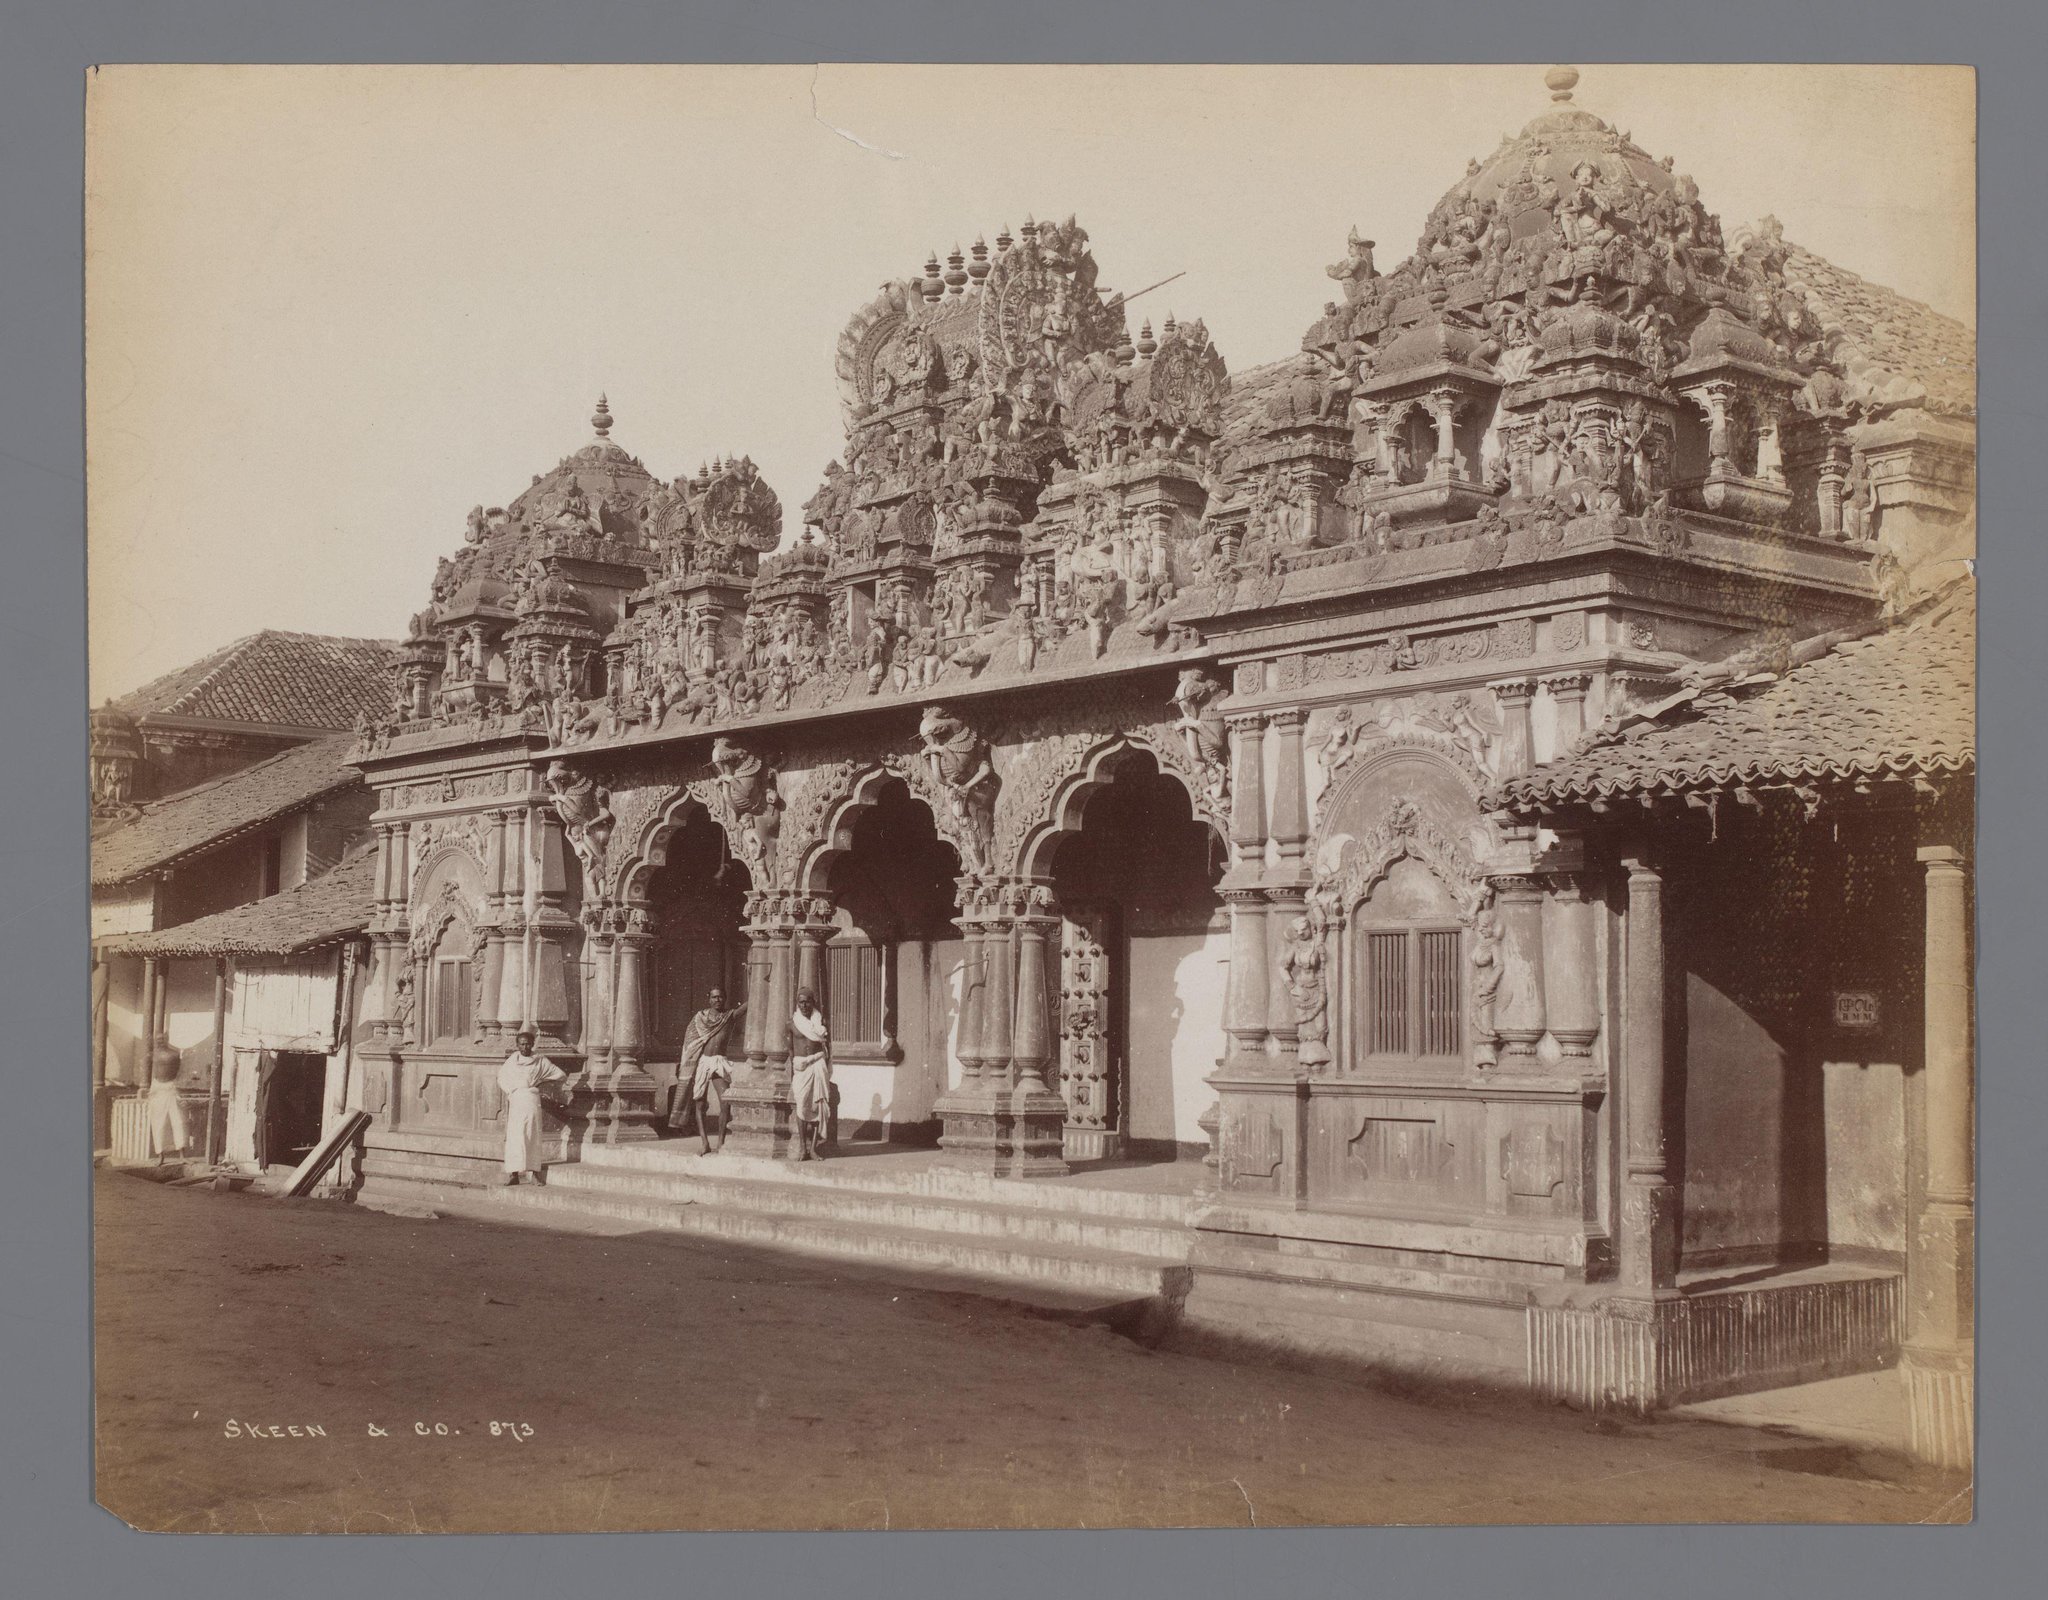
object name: photograph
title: Hindu temple with priests, Colombo, Sri Lanka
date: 1875-1910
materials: paper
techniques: albumen print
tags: sri lanka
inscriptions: name: ‘Skeen & Co.’, number: ‘873’